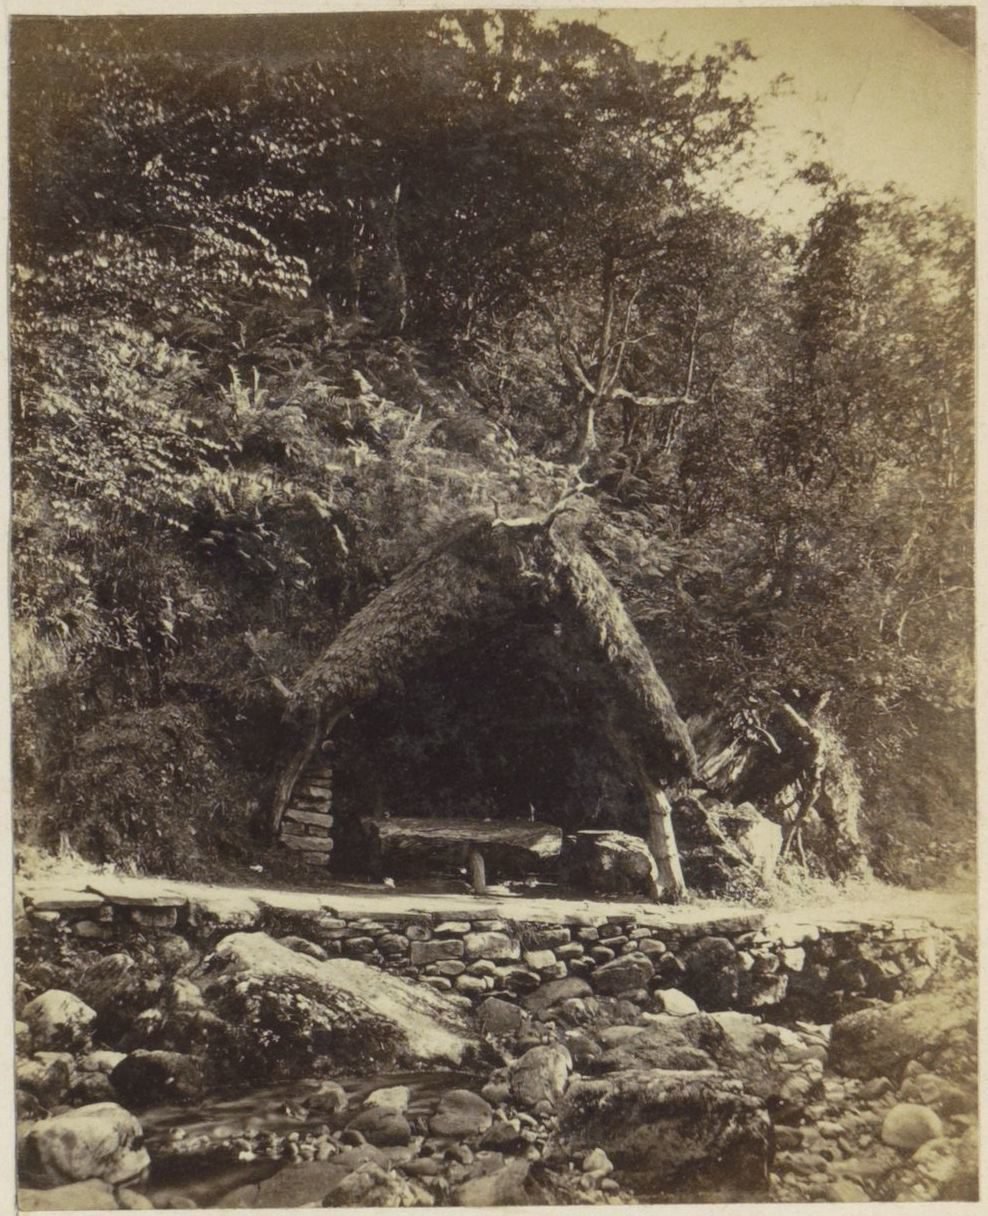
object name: photograph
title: Primitieve schuilhut langs een weg in Engels landschap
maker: Anonymous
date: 1850-1870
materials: paper, photographic support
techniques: albumen print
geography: england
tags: hut, cabin, lodge, england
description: Onderdeel van Album met foto's van bezienswaardigheden en landschappen in Engeland en van kunst.